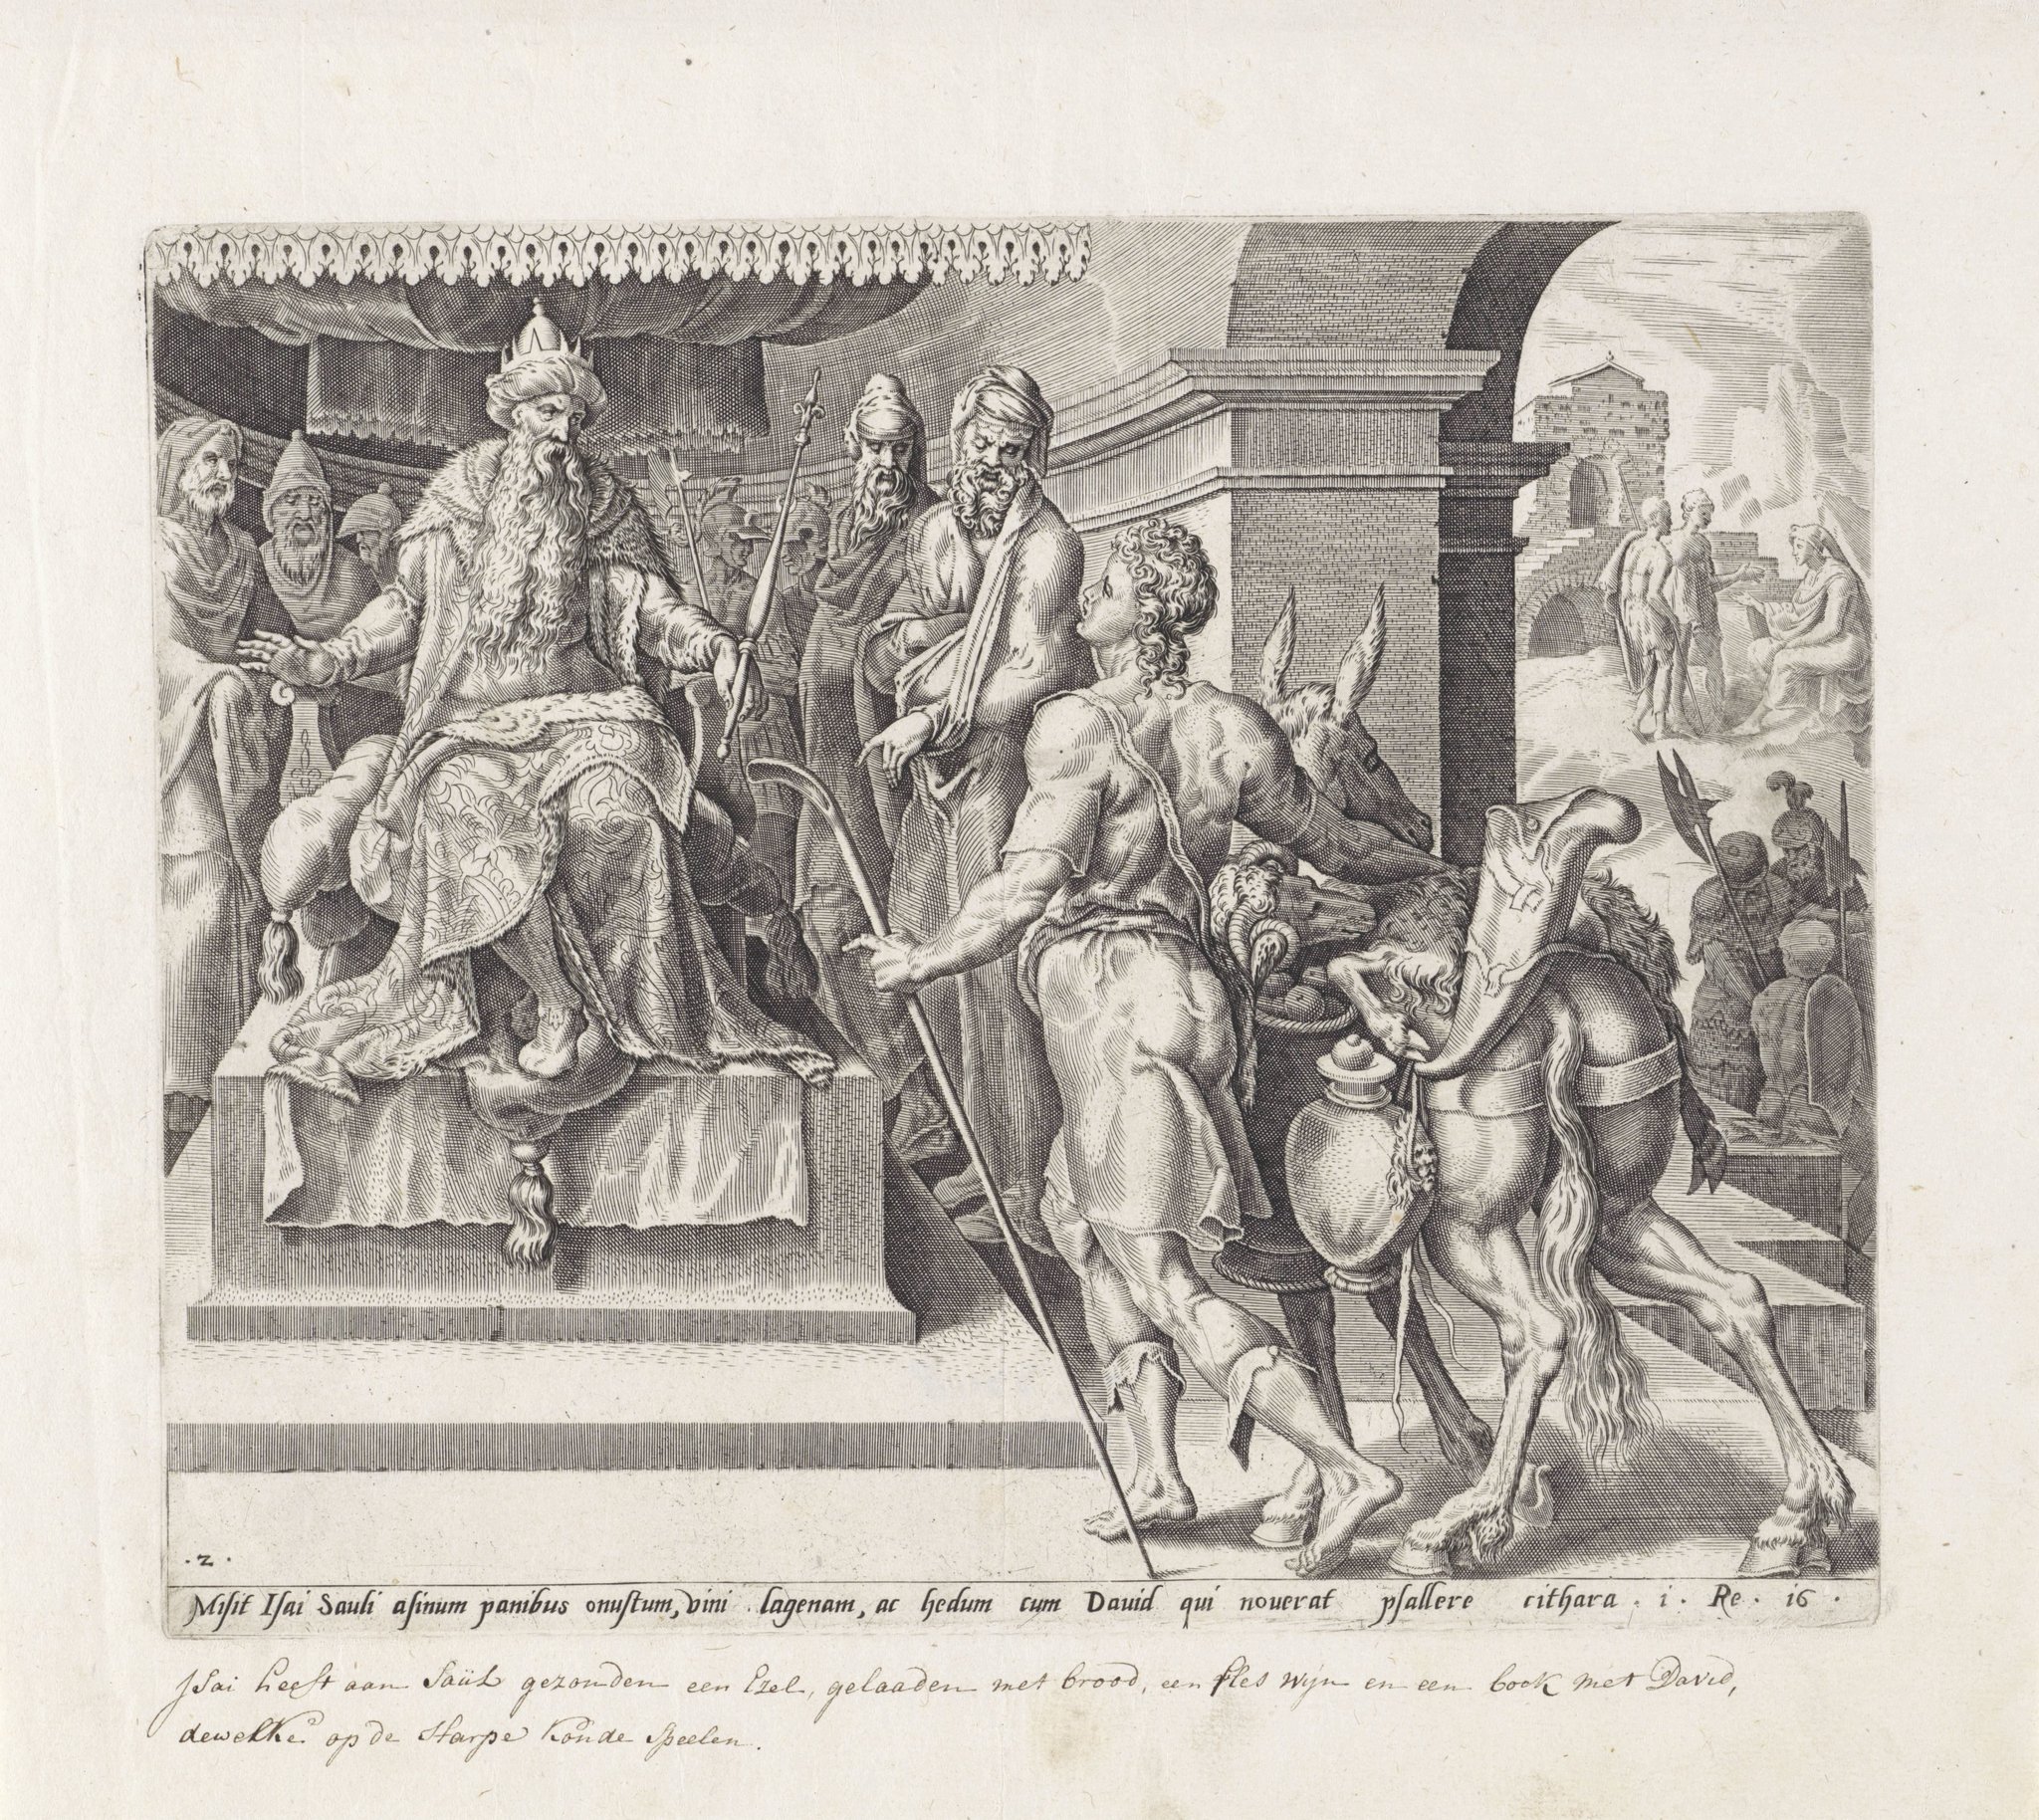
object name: print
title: Verhaal van David en Saul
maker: Anonymous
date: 1555-1633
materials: paper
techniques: engraving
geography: low countries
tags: david as a young man comes to saul's court with presents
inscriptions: collector's mark: Lugt 2228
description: David staat voor Saul, nadat hij door de koning was ontboden vanwege zijn goede reputatie als harpist. Naast David een ezel met geschenken voor Saul. In de marge een éénregelig onderschrift in het Latijn uit 1 Sam. (foutief aangeduid als 1 Koningen op de prent).